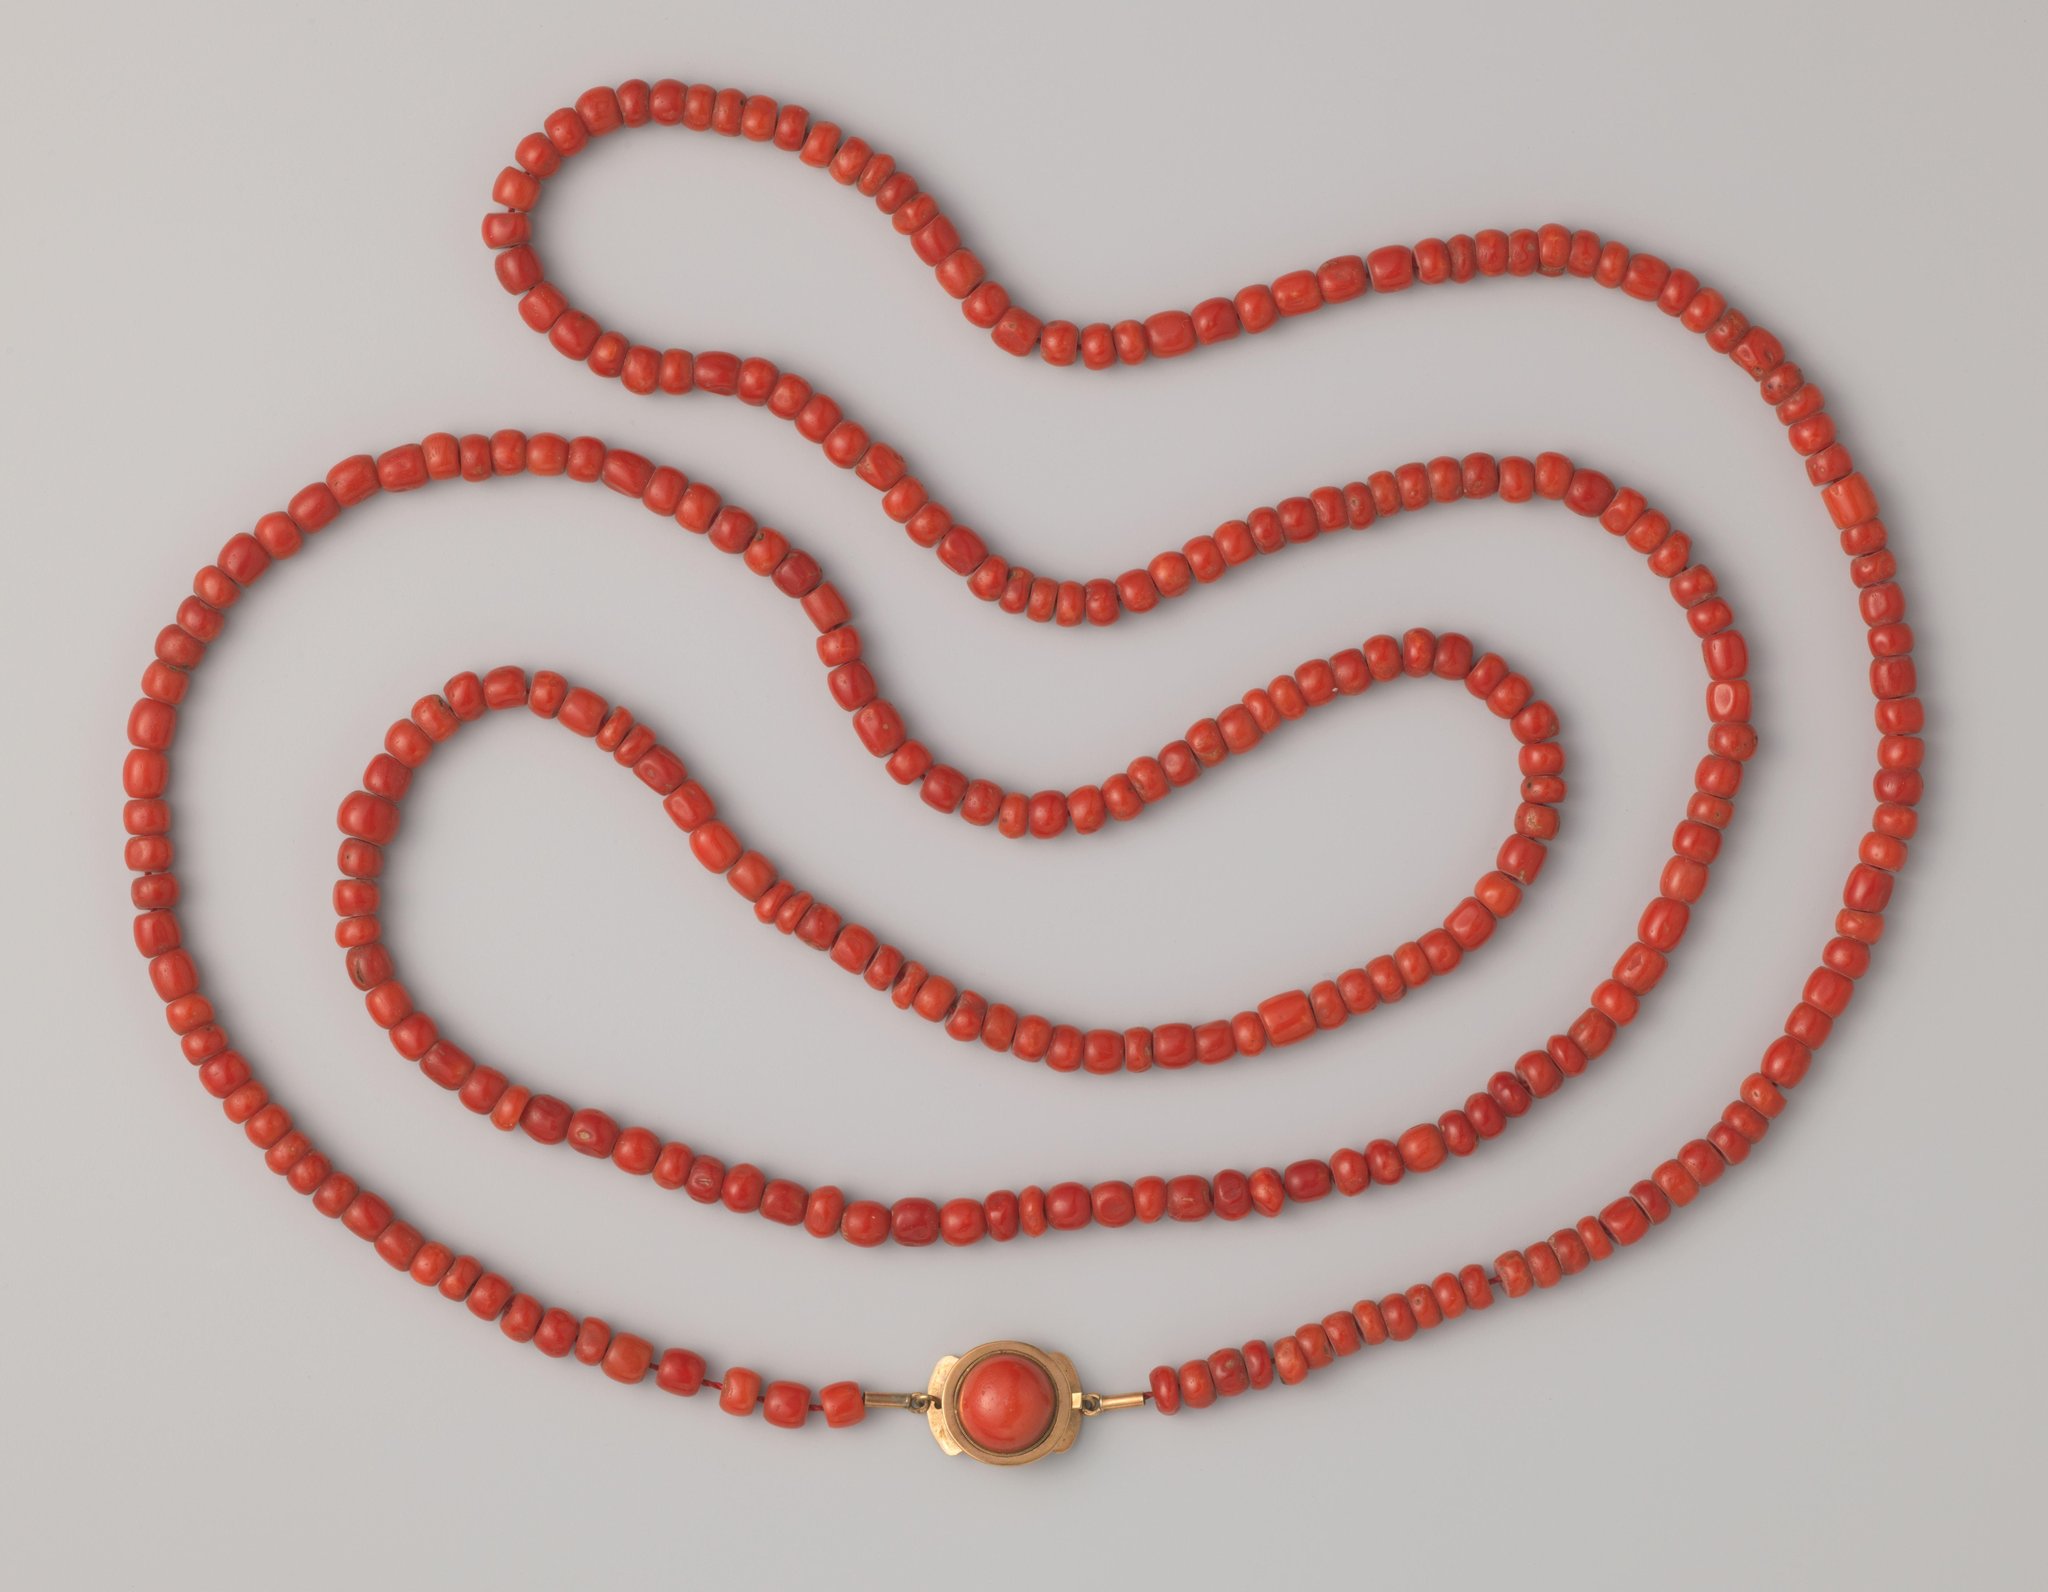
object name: streeksieraad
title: Halsketting met bloedkoraal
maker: h.c.f. ruff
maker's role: jeweler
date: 1915-1917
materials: gold, coral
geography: sloten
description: Halsketting van geregen bloedkoralen met een gouden slot. Het slot is gemerkt.